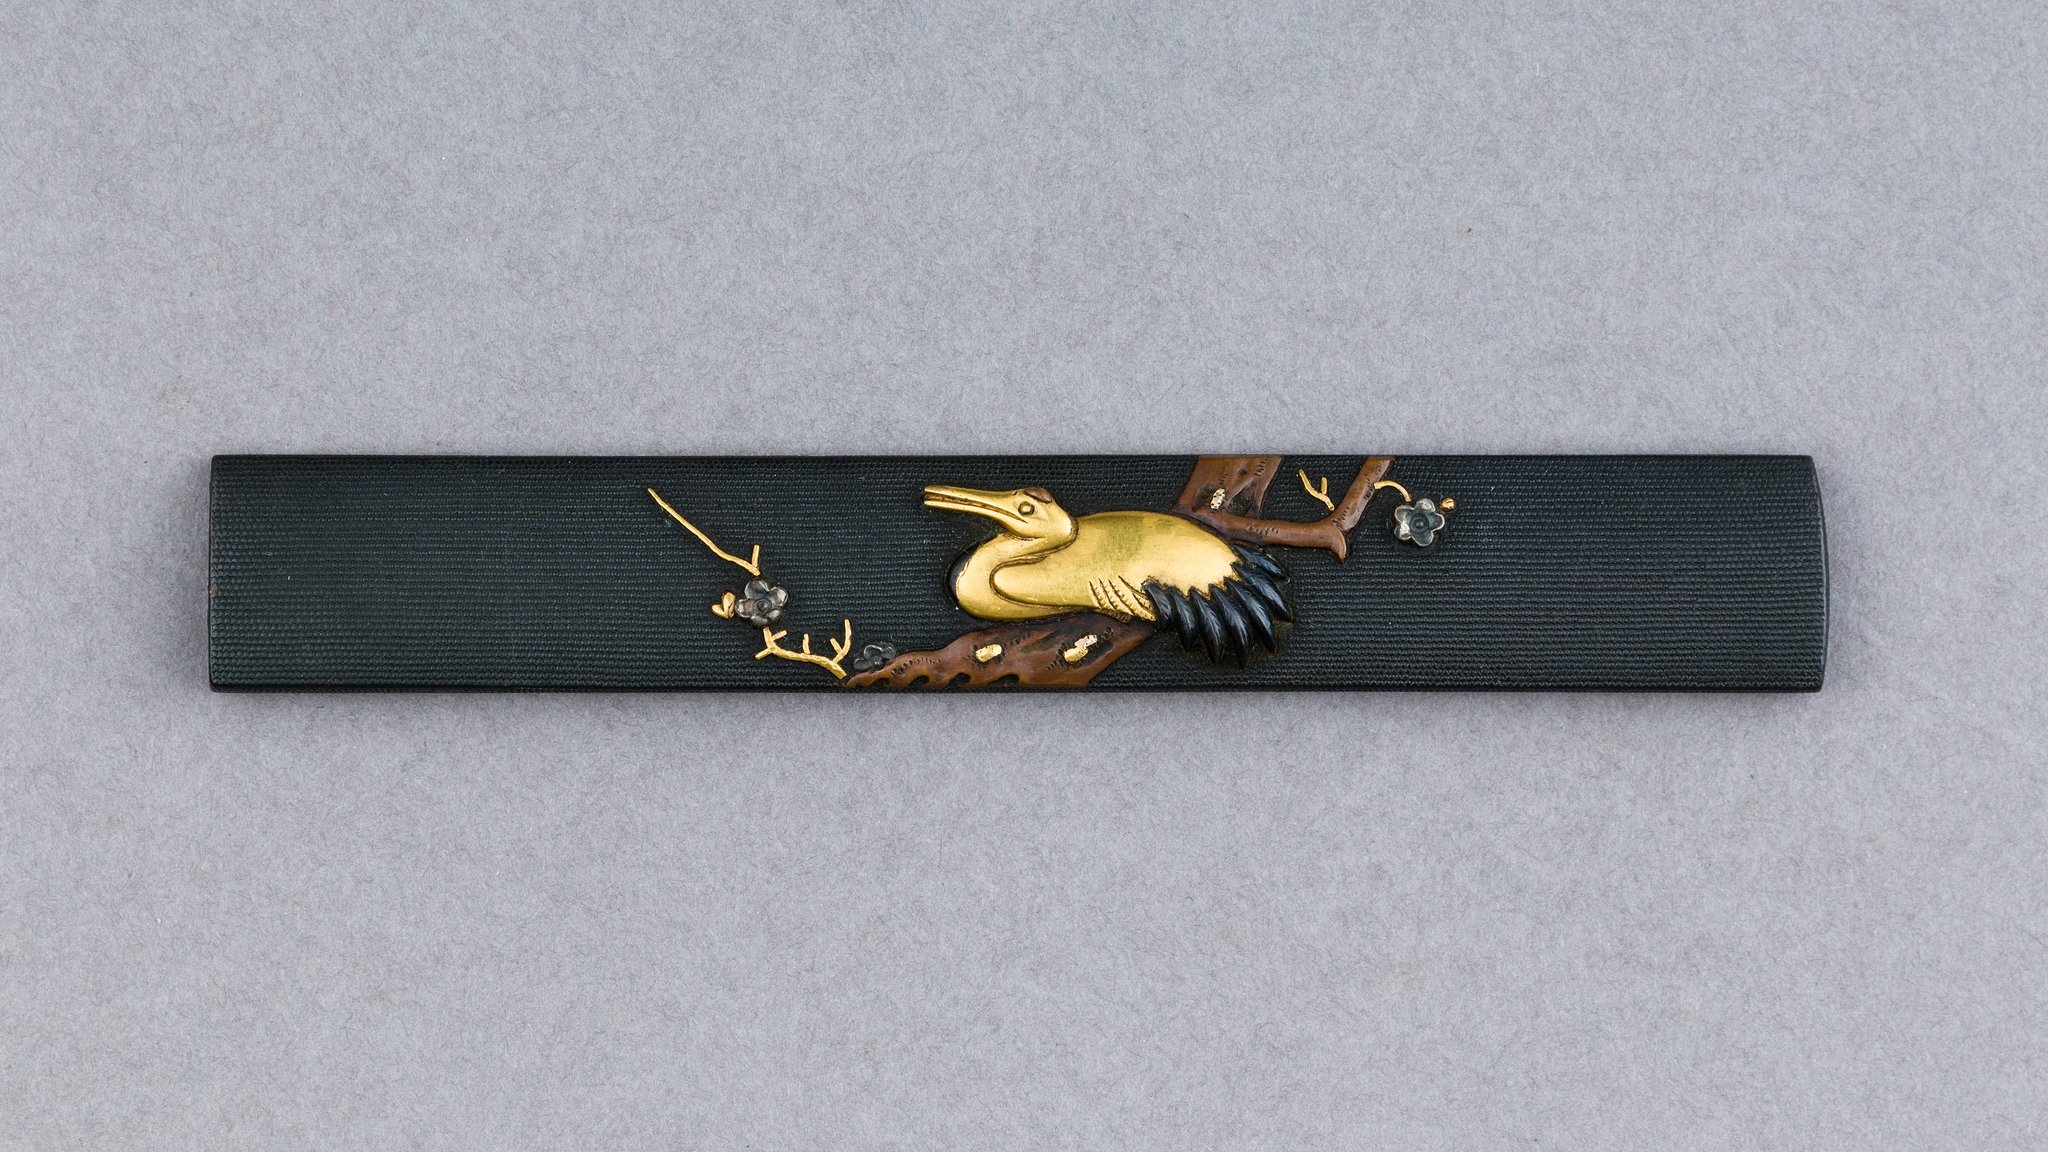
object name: knife handle kozuka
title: Knife Handle (Kozuka)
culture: japanese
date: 1615-1868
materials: copper, gold alloy, gold, silver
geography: japan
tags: birds